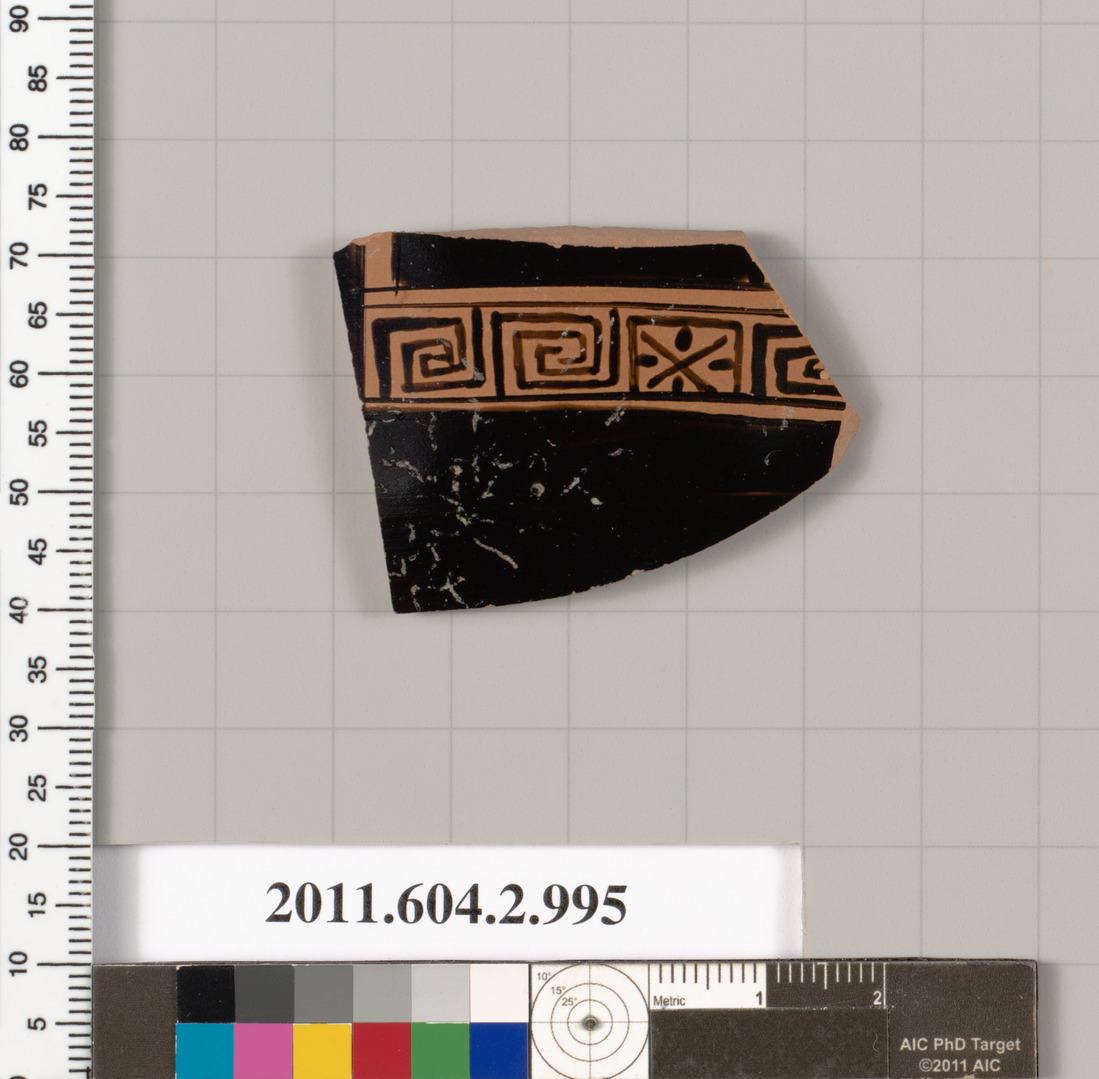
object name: oinochoe fragment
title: Terracotta fragment of an oinochoe (jug)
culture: greek, attic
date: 460-440 BCE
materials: terracotta